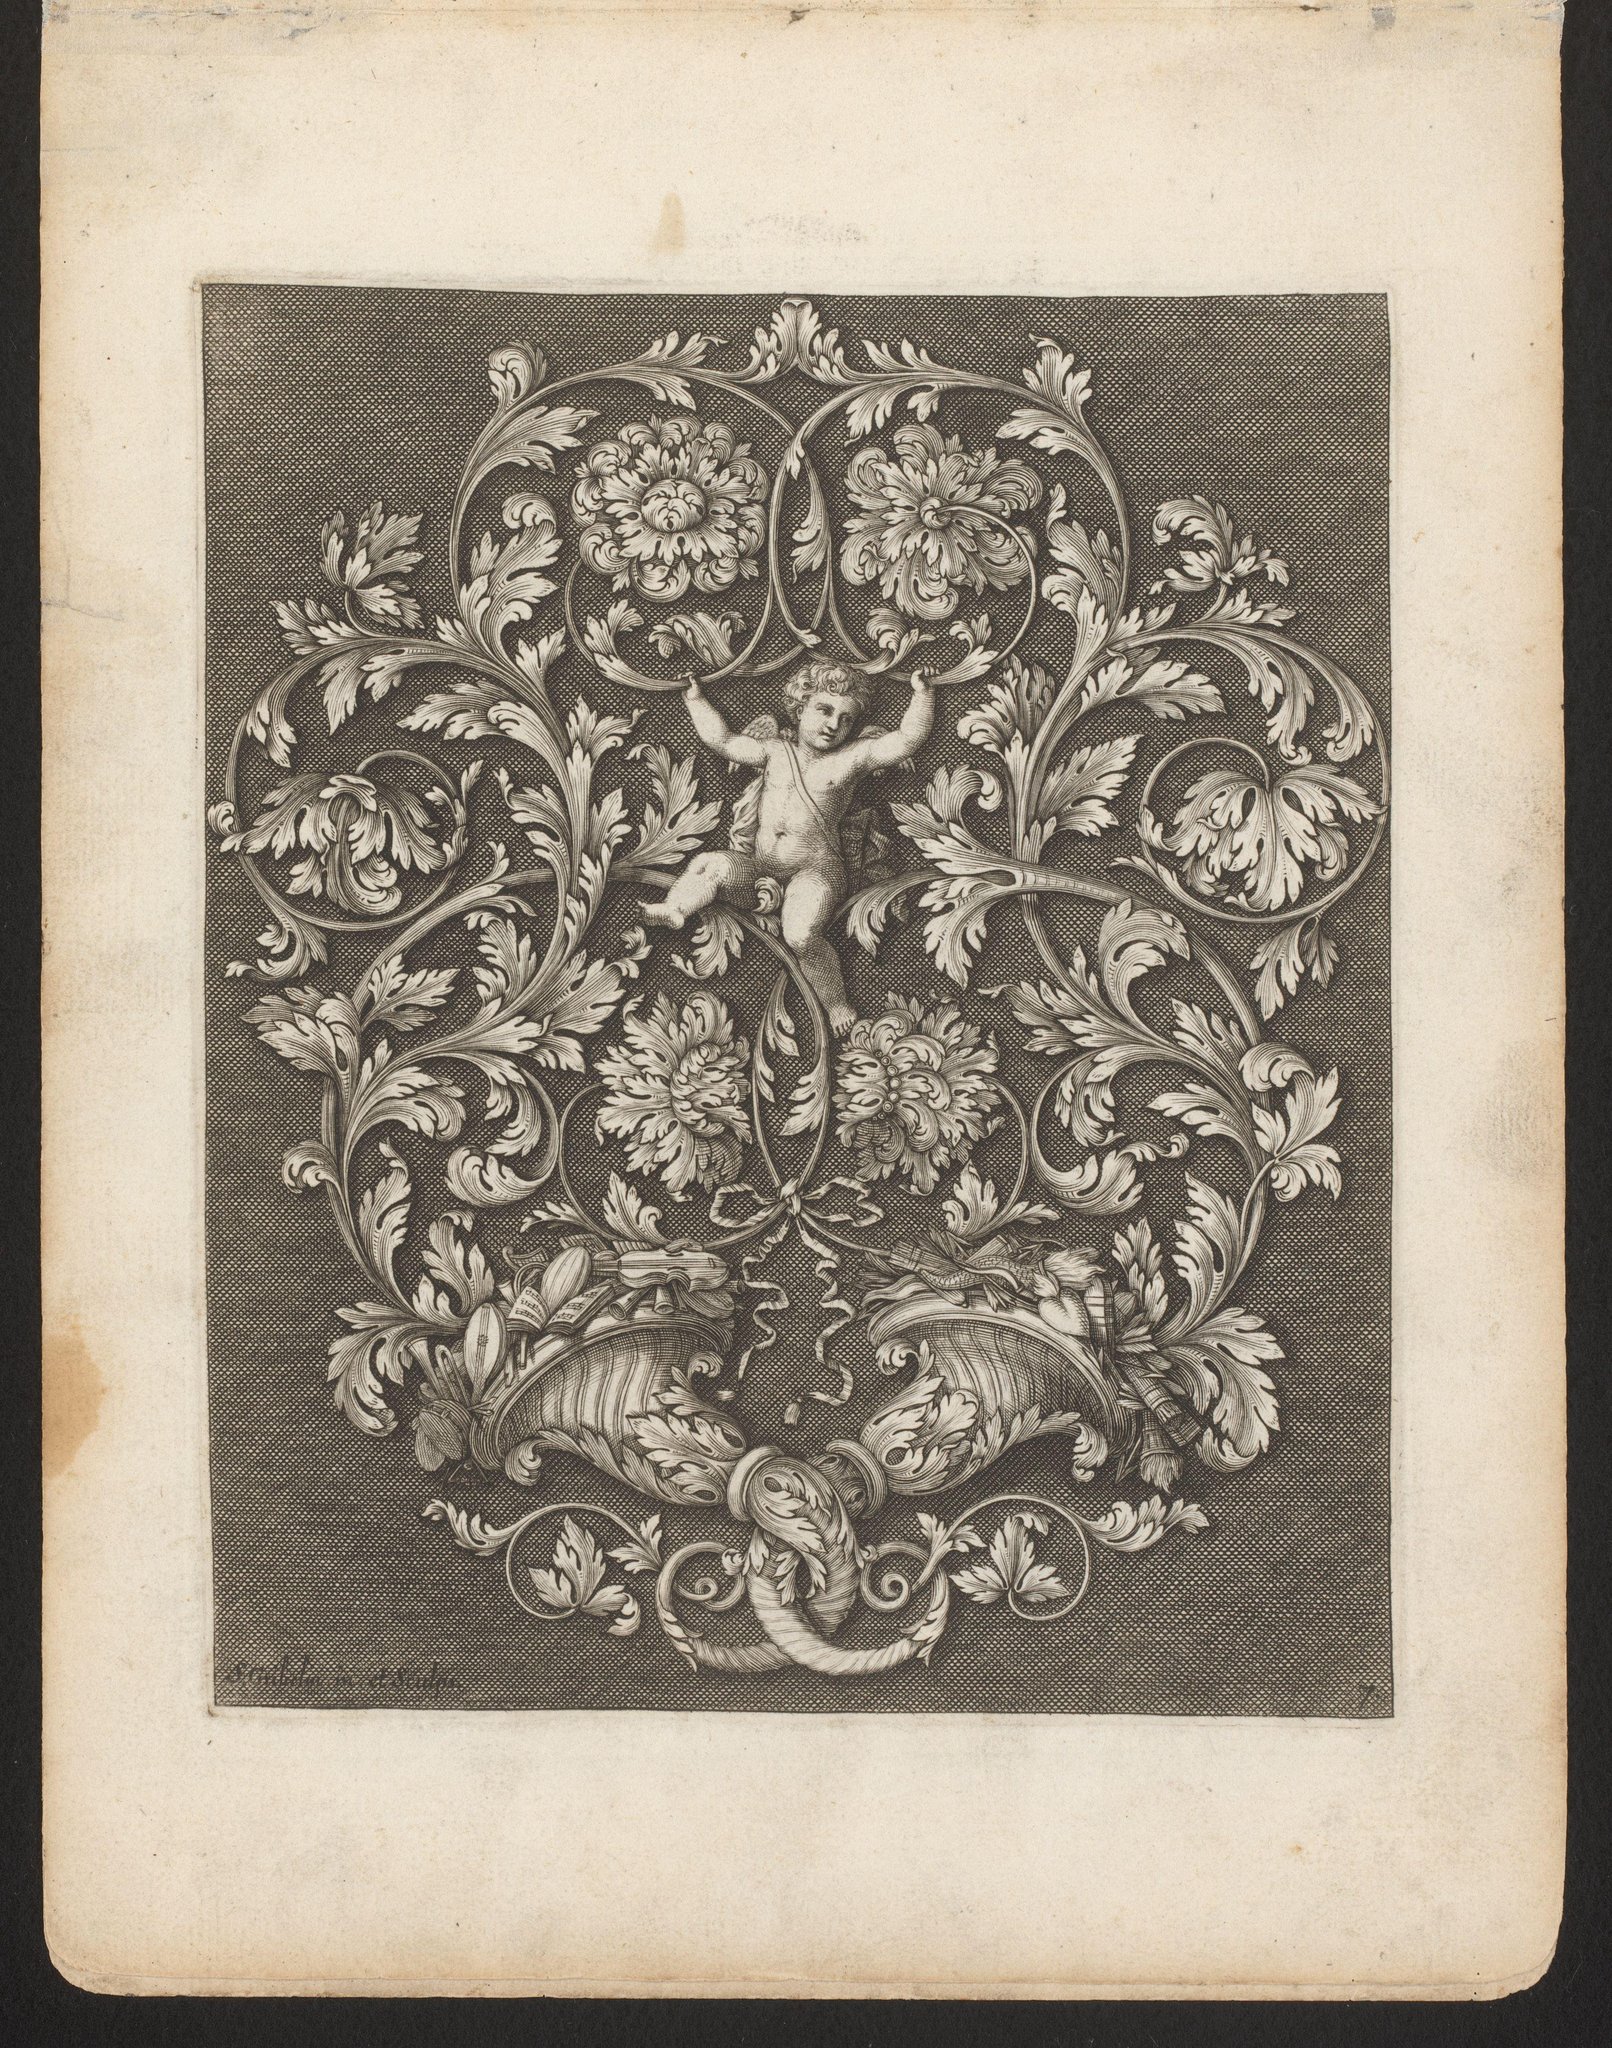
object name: print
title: Boek met ornamentprenten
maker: simon gribelin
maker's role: print maker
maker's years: 1661-1733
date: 1704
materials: paper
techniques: engraving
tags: 'cornucopia', horn of plenty, ornaments ~ art, cupids: 'amores', 'amoretti', 'putti', ornament derived from plant forms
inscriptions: collector's mark: Lugt 2760, collector's mark: Lugt 2228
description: De eerste versie van deze prentserie is uitgegeven in 1682 met de titel 'A Book of Severall Ornaments'.